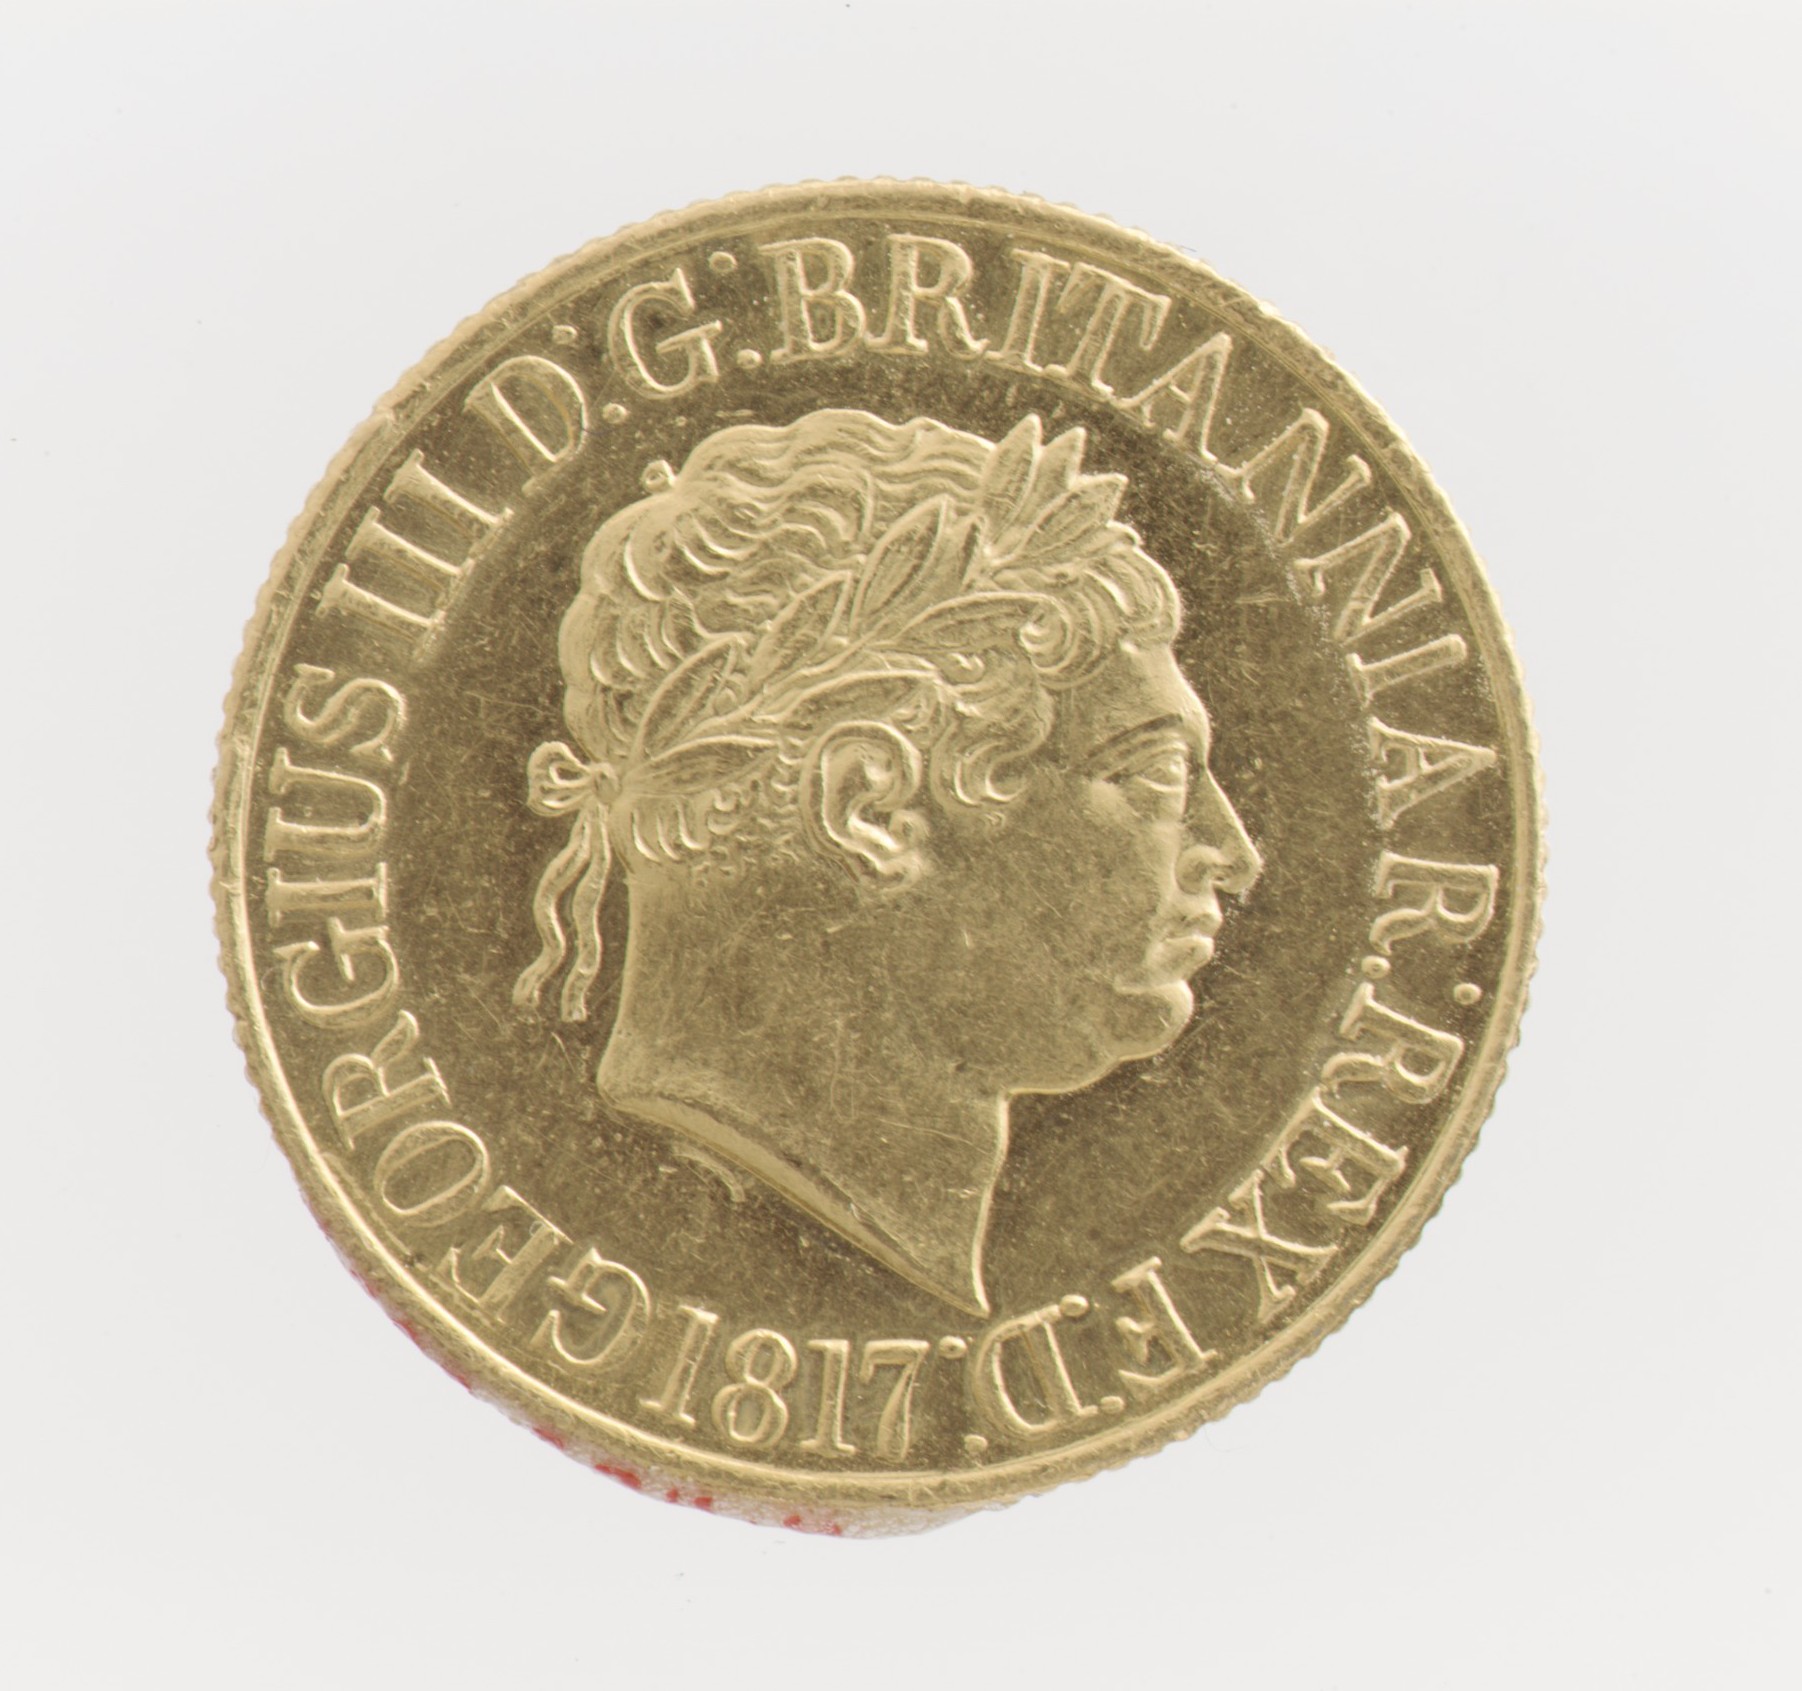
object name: sovereign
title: George III pattern sovereign with St. George reverse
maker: benedetto pistrucci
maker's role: maker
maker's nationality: italian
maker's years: 1783-1855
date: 1817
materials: gold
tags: kings,profiles,horses